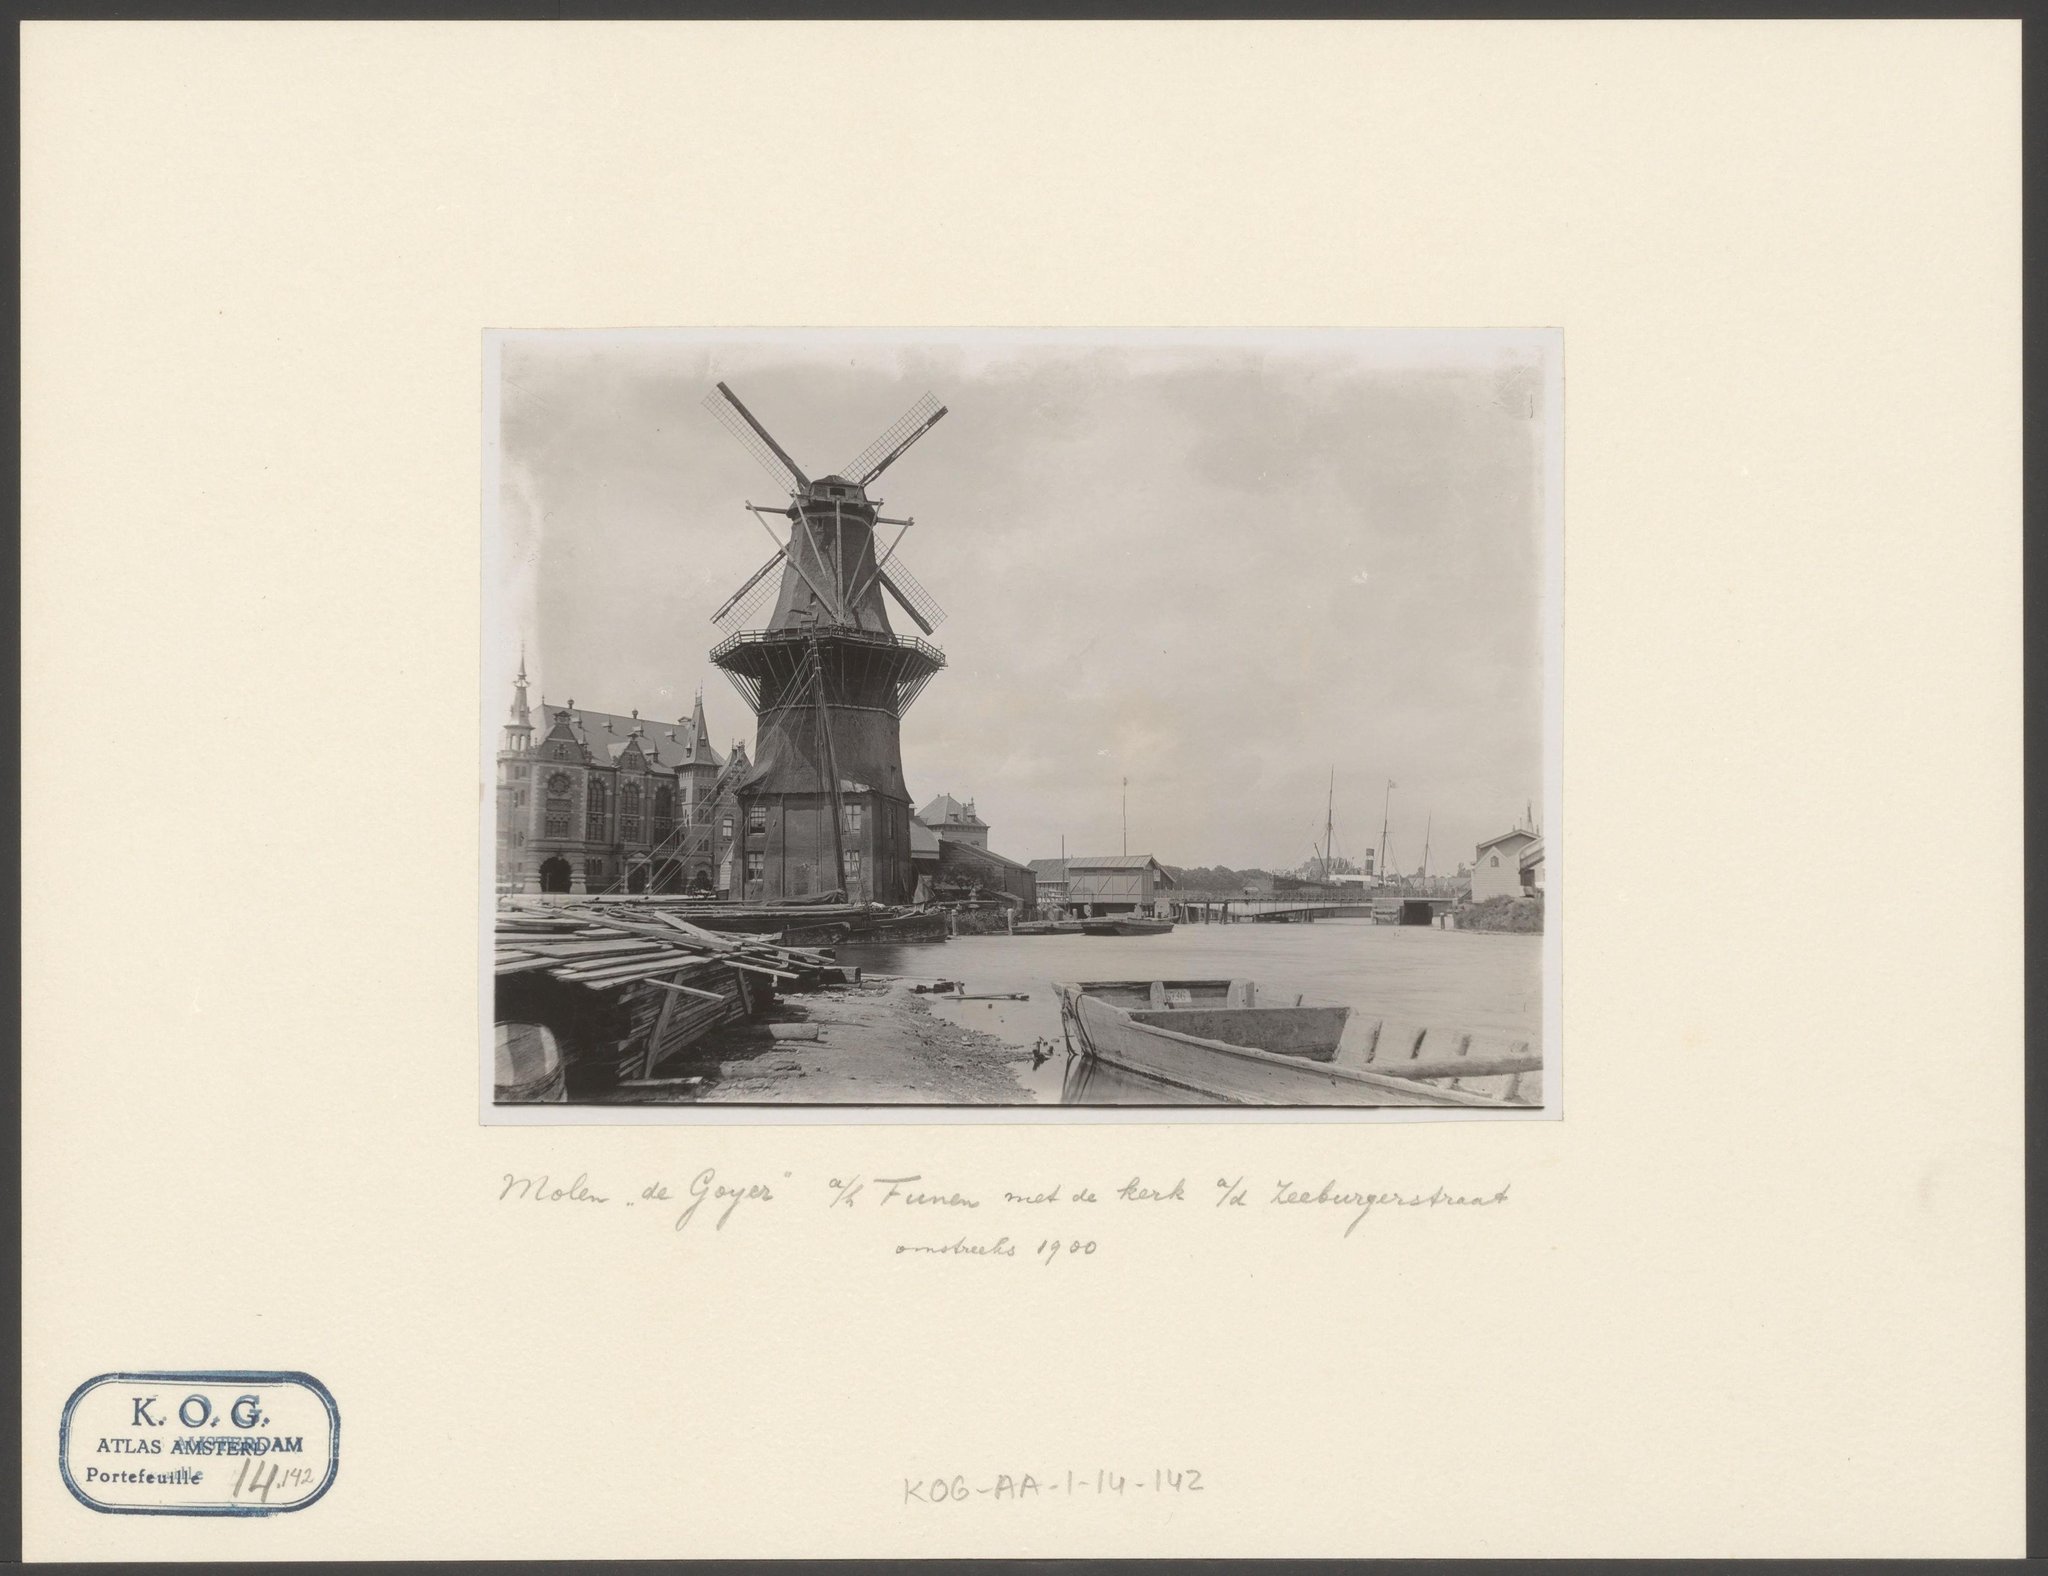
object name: photograph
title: Gezicht op molen De Gooyer aan het Funen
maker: Anonymous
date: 1900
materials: paper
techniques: gelatin silver print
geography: amsterdam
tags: city-view in general; 'veduta', canal, windmill in landscape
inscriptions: collector's mark: ‘14.142’ Lugt 1641b, inscription: ‘Molen "de Goyer" a/h Funen met de kerk a/d Zeeburgerstraat / omstreeks 1900’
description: Onderwerpsrubriek binnen de Atlas Amsterdam: Zaagmolensloot, Zandpad, Zeeburg, Zeeburgerdijk, Zeeburgerpad, Zeeburgerstraat, Zwanenburgwal, Zwartebijlsteeg.